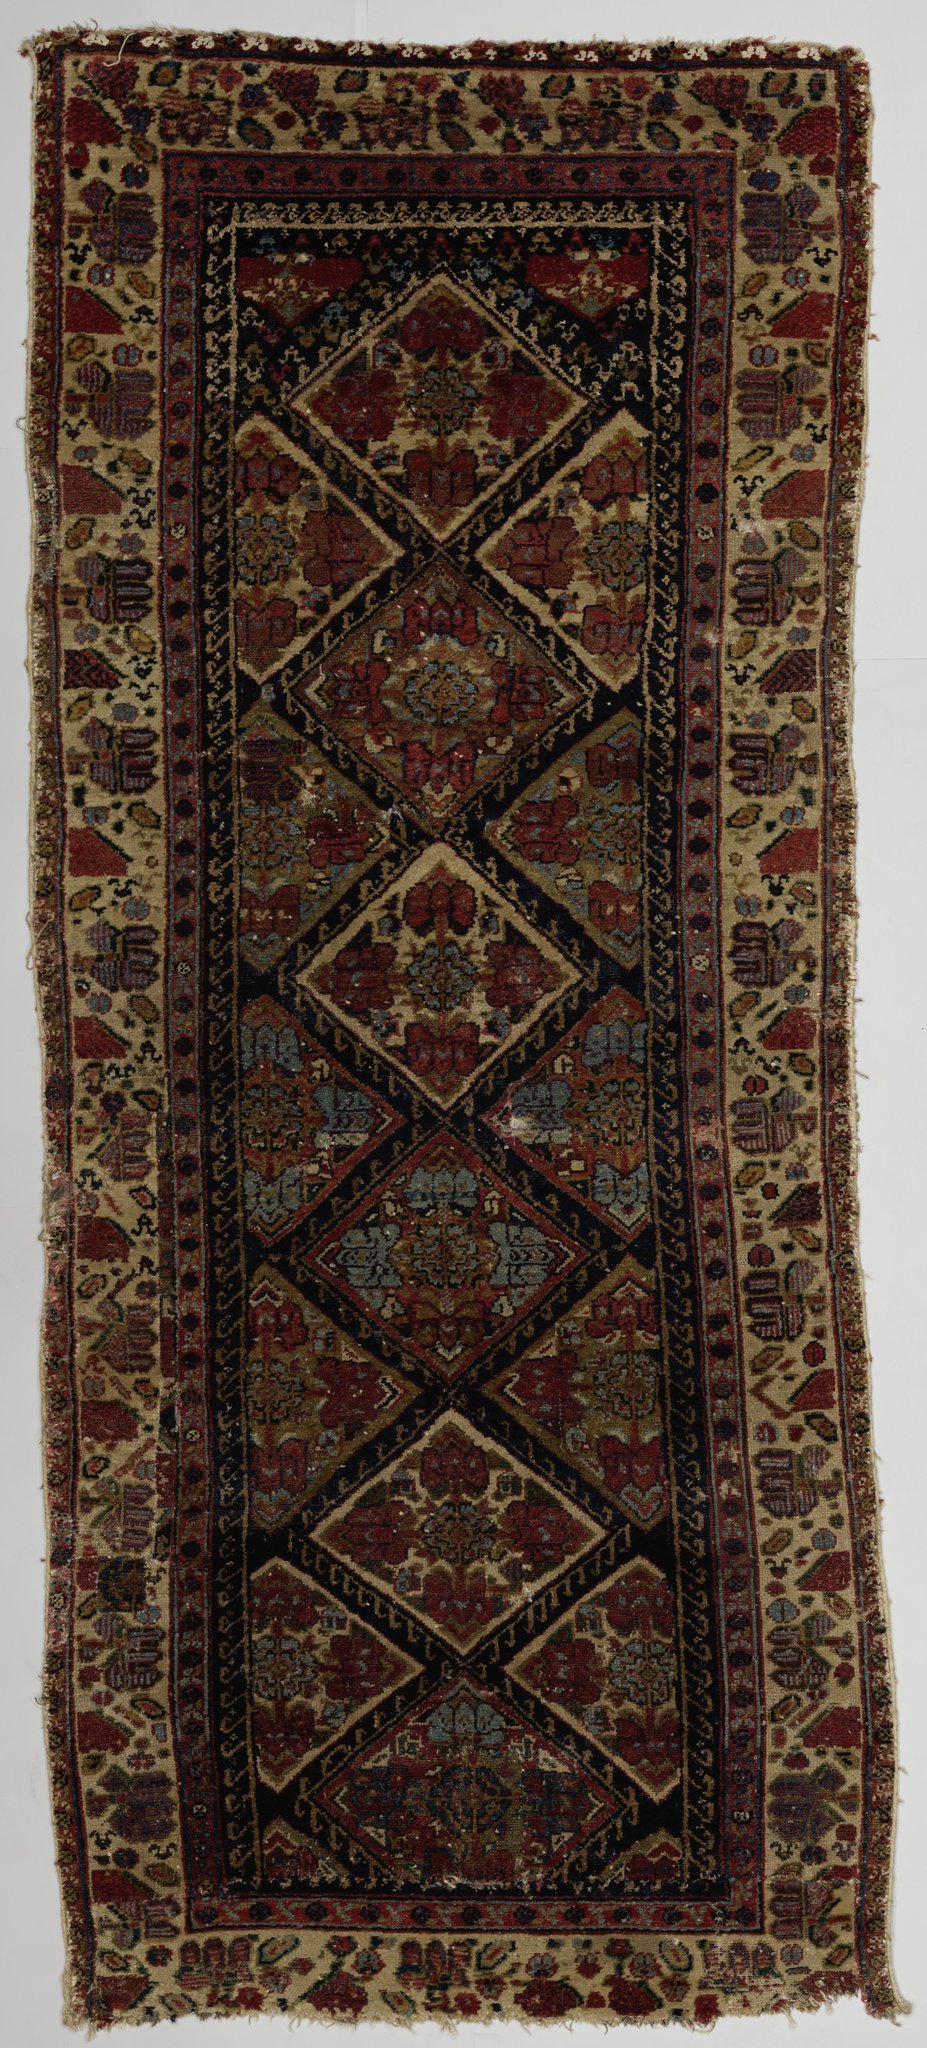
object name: oriental rug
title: Oosters tapijt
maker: Anonymous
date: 1850-1900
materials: cotton, wool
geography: karadagh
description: Oosters tapijt, ruitenkleed, in loper formaat. In het middenveld repeterende ruitvormige medaillons, gevuld met vierslagmotieven tegen een donkerblauw fond. Deze loper is ooit ingekort.